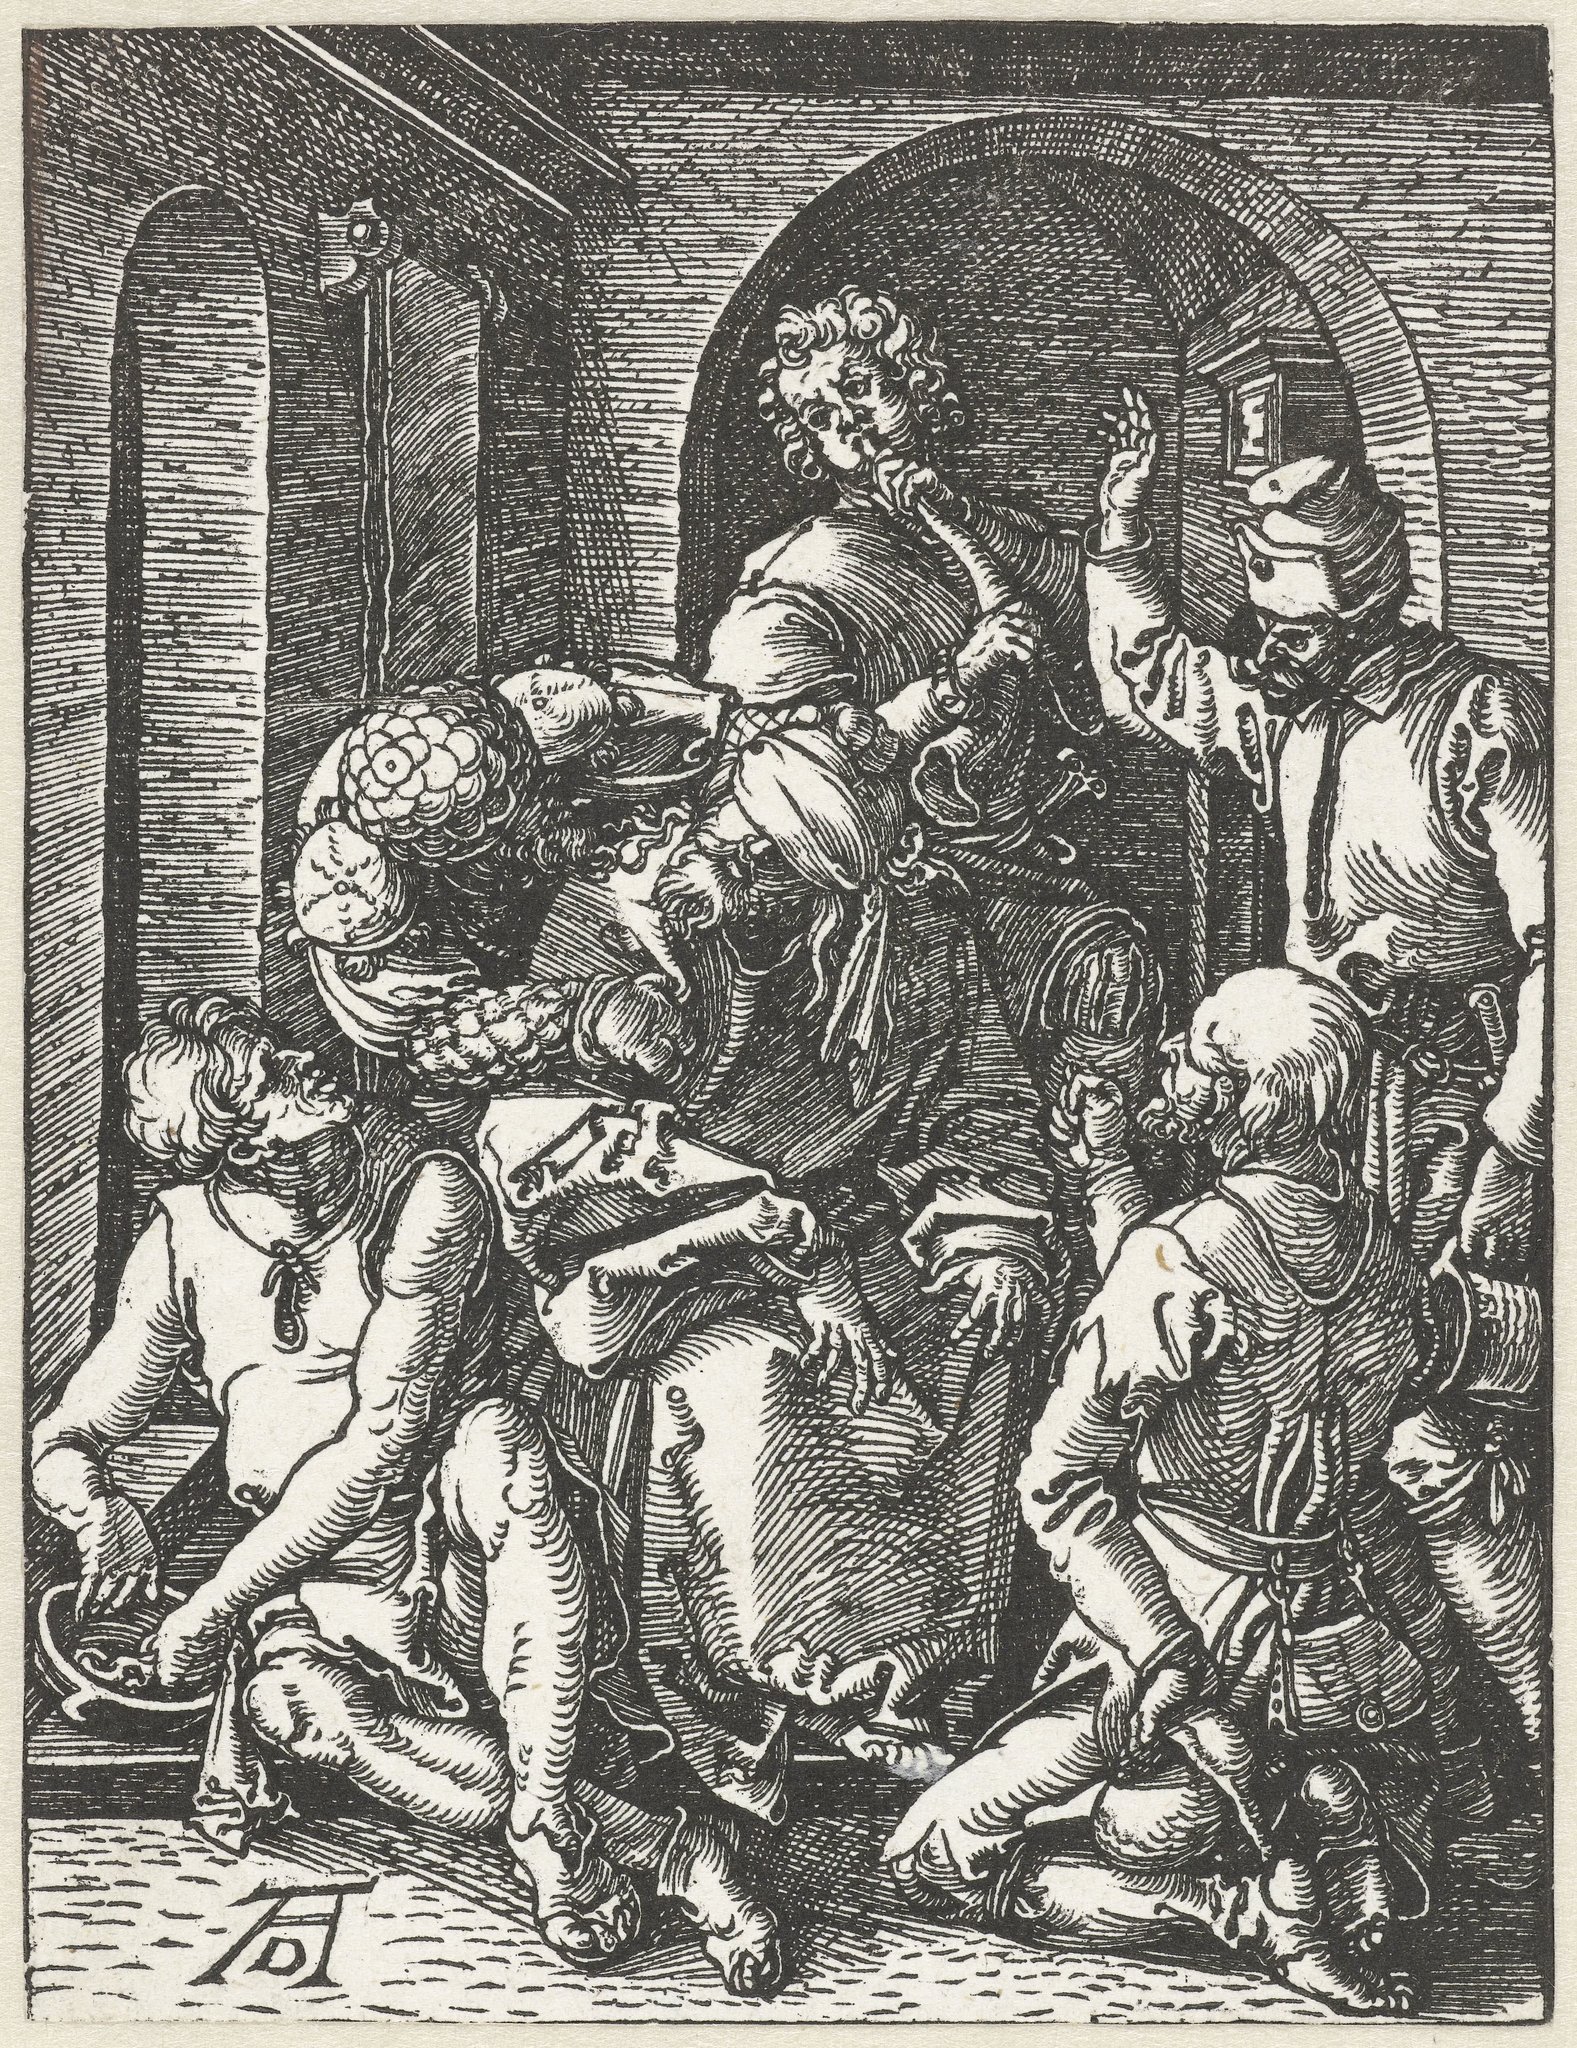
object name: print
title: De kleine Passie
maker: albrecht dürer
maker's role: draughtsman, painter, print maker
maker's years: 1471-1528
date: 1508-1509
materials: paper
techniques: woodcut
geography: nuremberg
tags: mockings of christ, who may be blindfolded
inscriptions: collector's mark: Lugt 2228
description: Christus wordt lastig gevallen en bespot door vijf mannen. Deze prent is onderdeel van de prentserie 'De kleine Passie', bestaande uit een titelprent en 36 bijbelse scènes (voornamelijk uit het Lijdensverhaal).